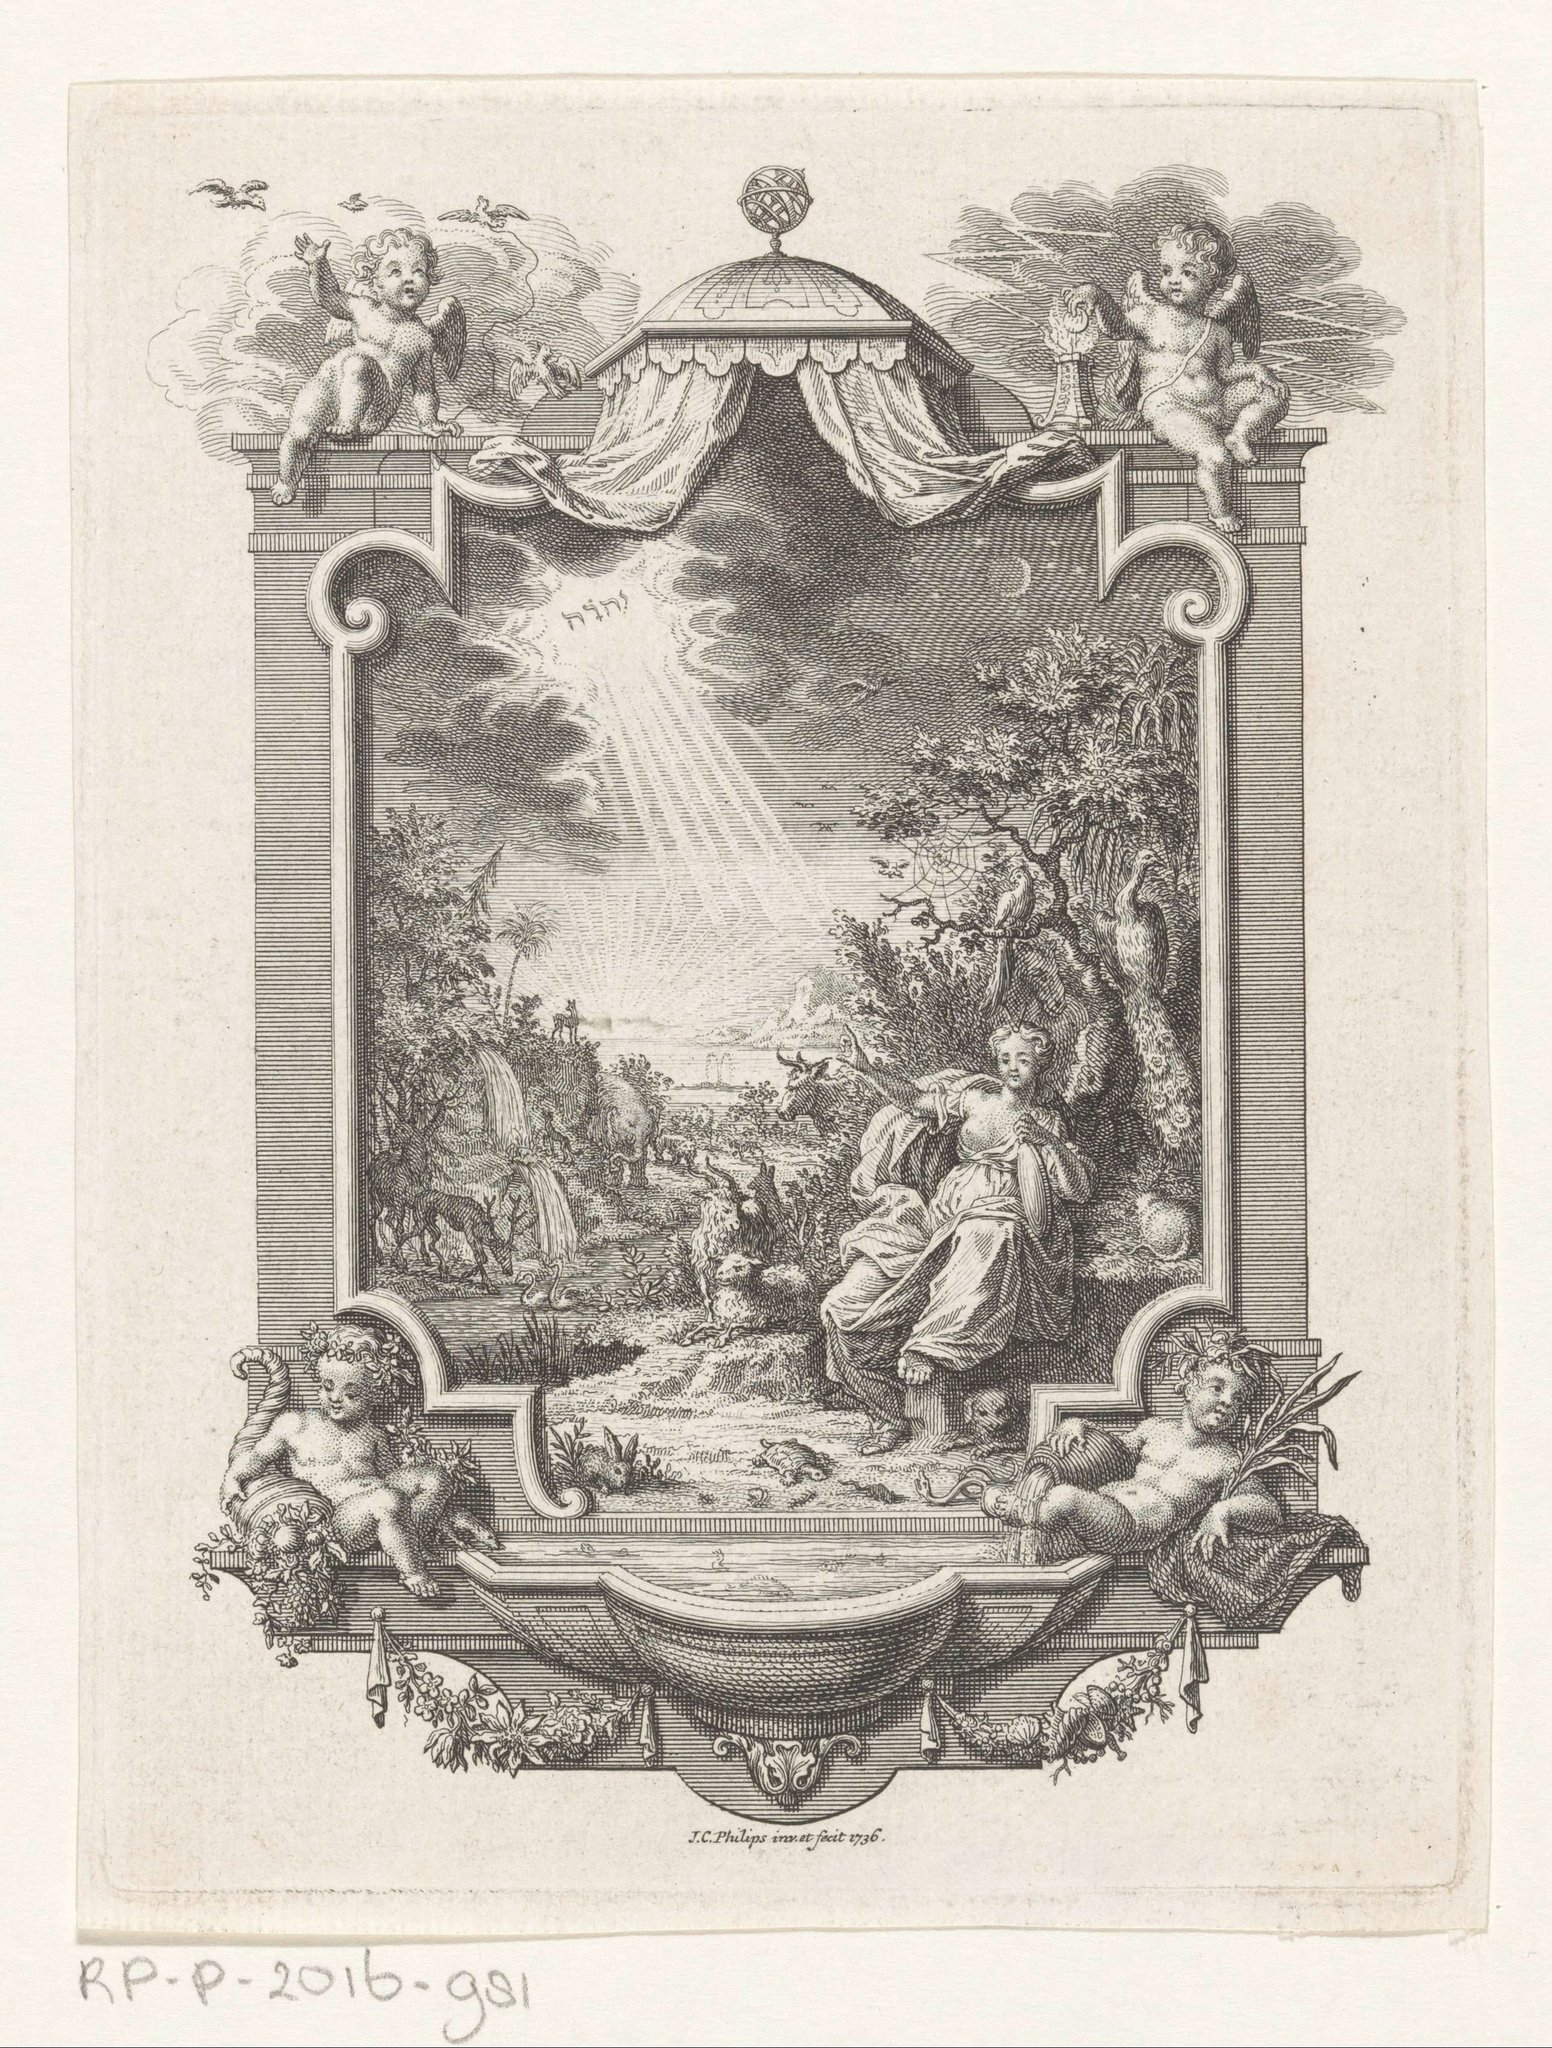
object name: print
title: Cartouche met allegorie op de schepping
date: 1736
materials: paper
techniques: engraving, etching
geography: amsterdam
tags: tetragram (in roman or hebrew script) ~ symbol of god the father, globe, the six days of creation (genesis 1:3-25)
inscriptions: collector's mark: Lugt 2228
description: Allegorie op de schepping: een paradijselijk landschap met allerlei dieren op het land, in de lucht en in het water. De maan en sterren staan aan de hemel. Rechts op de voorgrond een vrouw, gekroond met een passer, wijzend naar een tetragram, dat als symbool van God de Vader aan de hemel staat. De voorstelling is gevat in een cartouche, bekroond met een globe en vier putti op de hoeken.